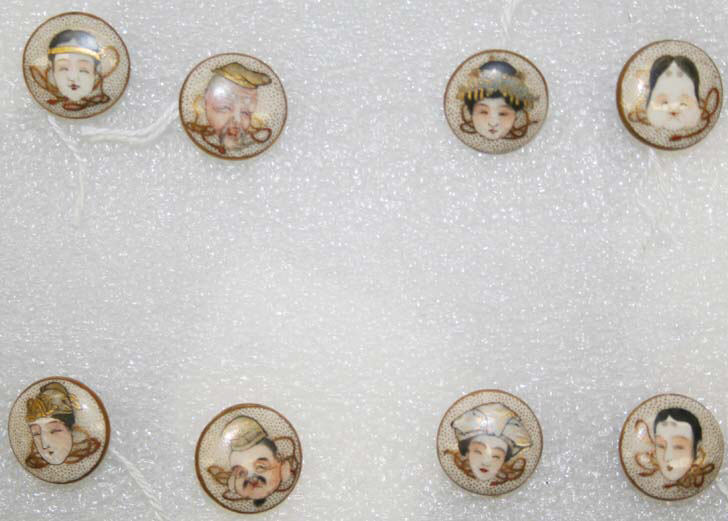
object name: button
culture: japanese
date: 1850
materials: metal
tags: masks